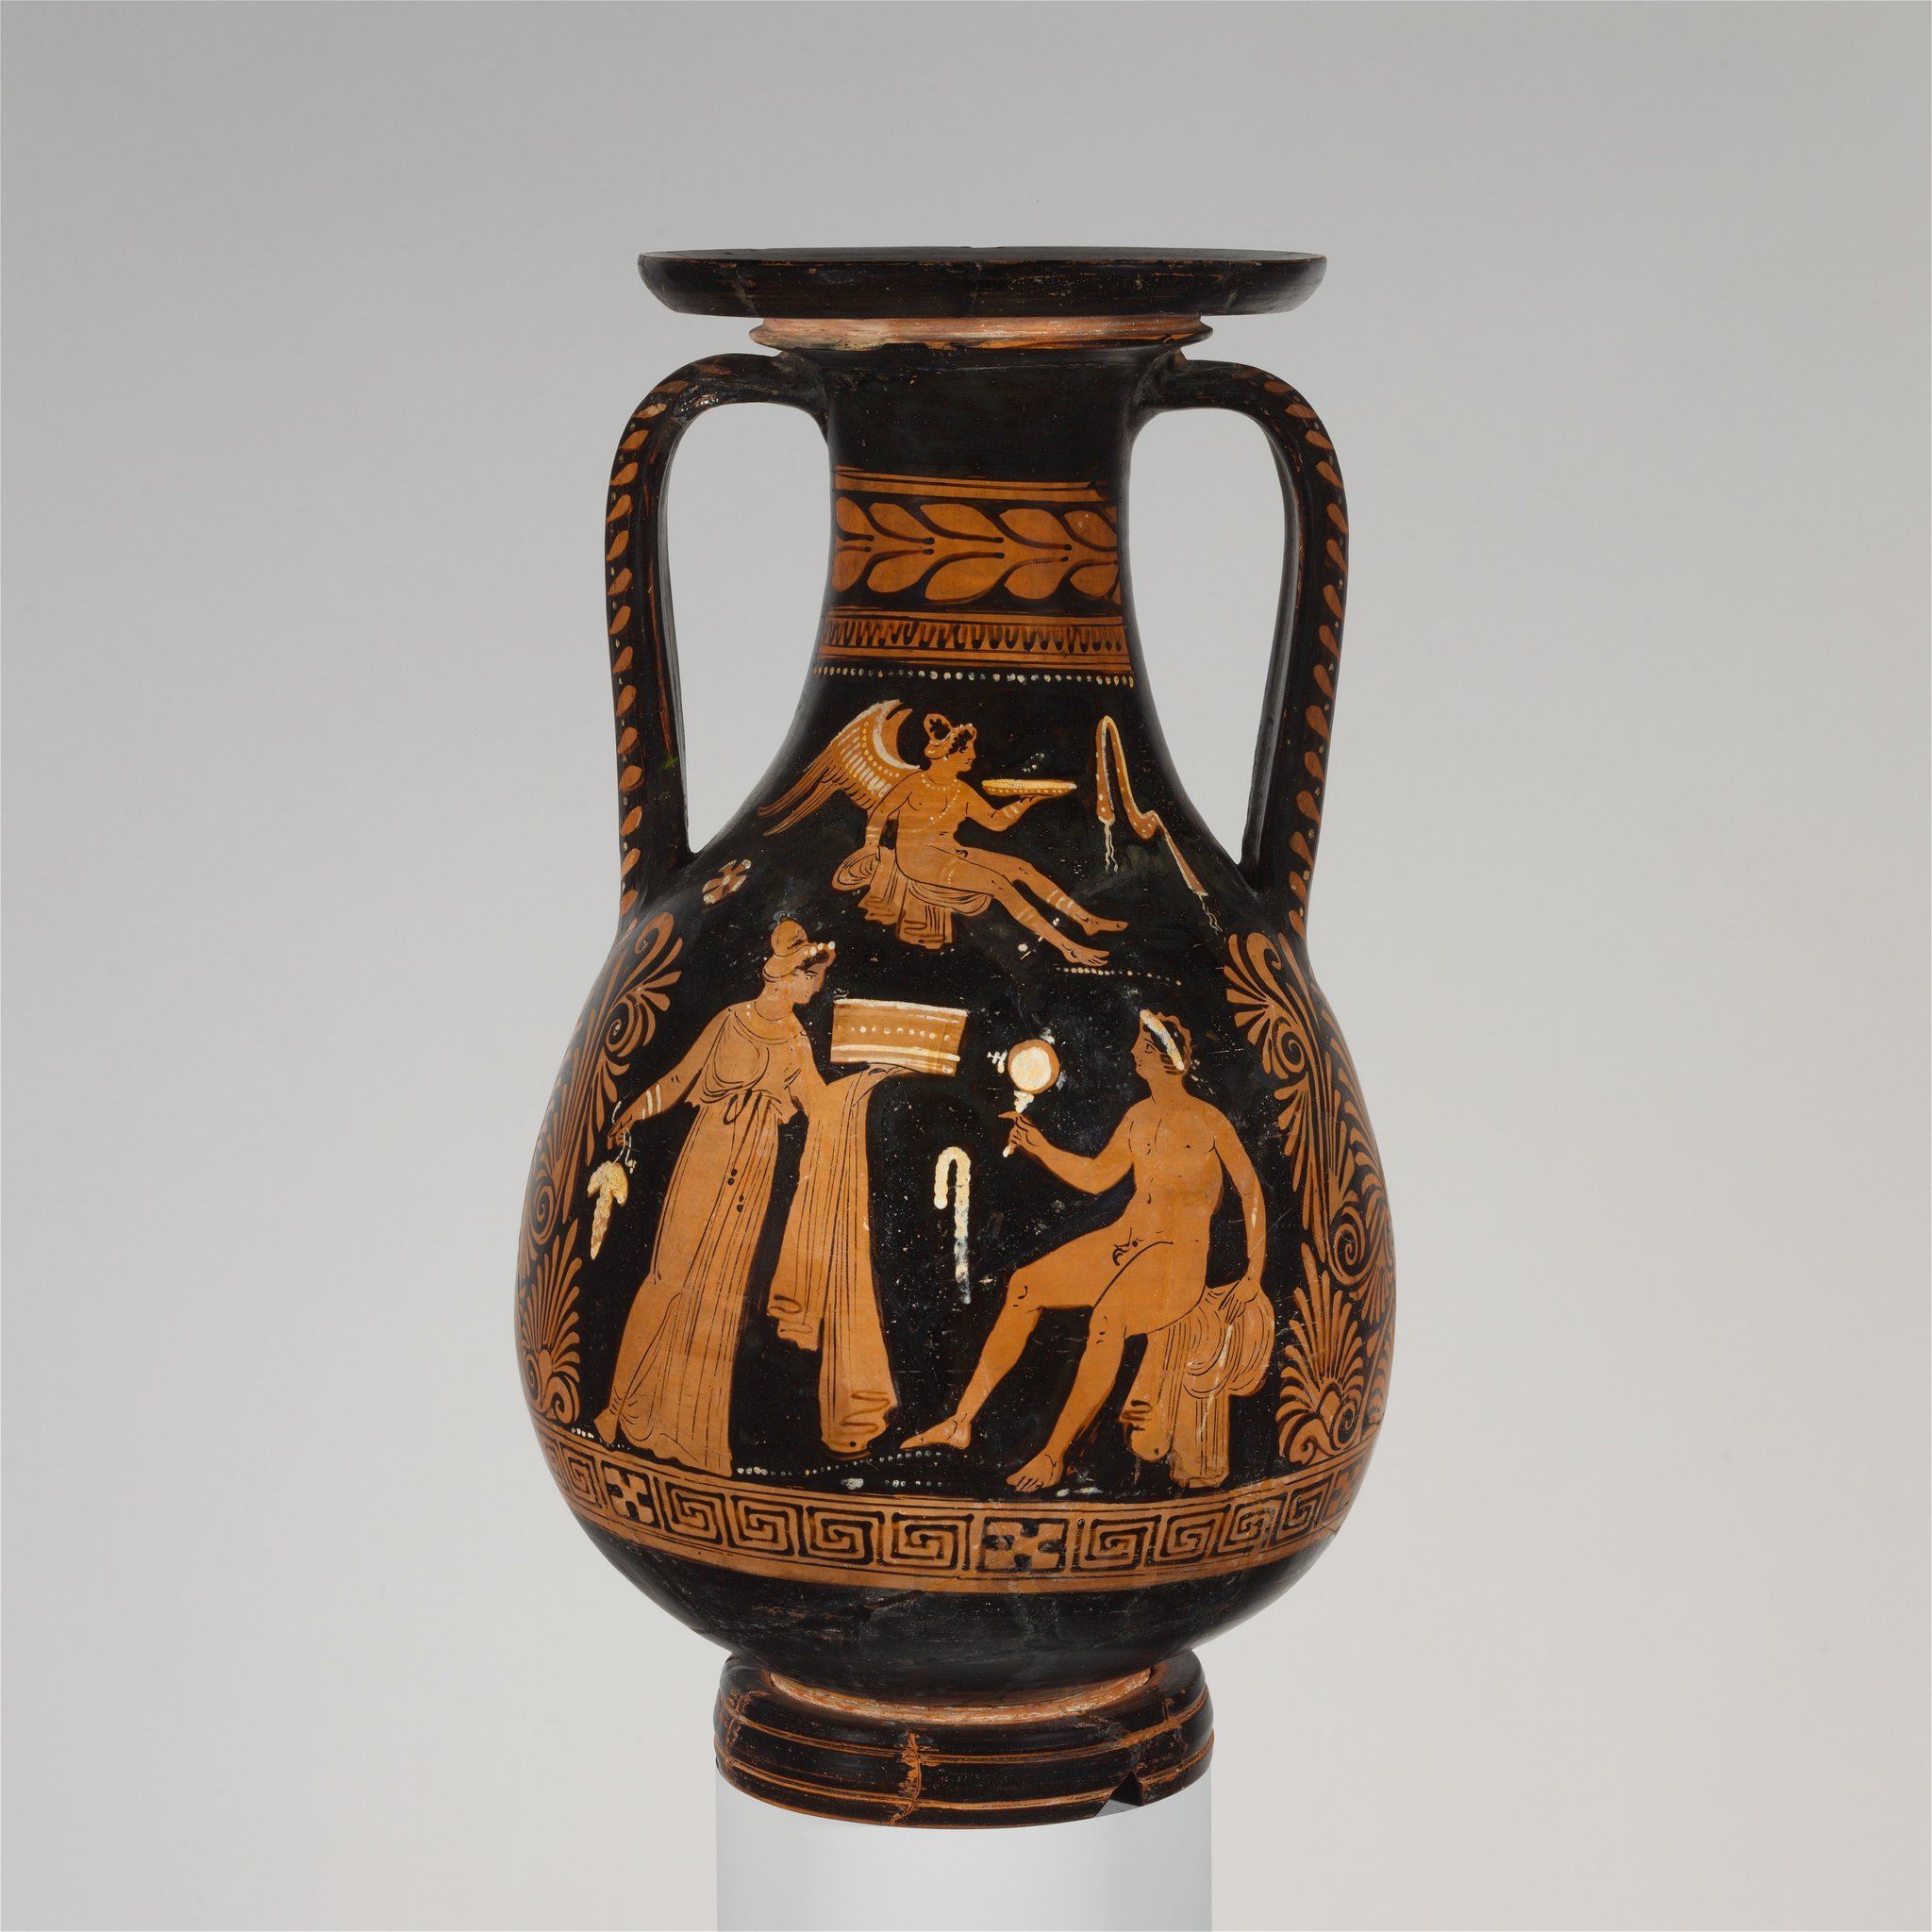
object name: pelike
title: Terracotta pelike (jar)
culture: greek, south italian, apulian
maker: underworld painter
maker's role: artist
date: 330-310 BCE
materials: terracotta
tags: male nudes,women,eros,swans